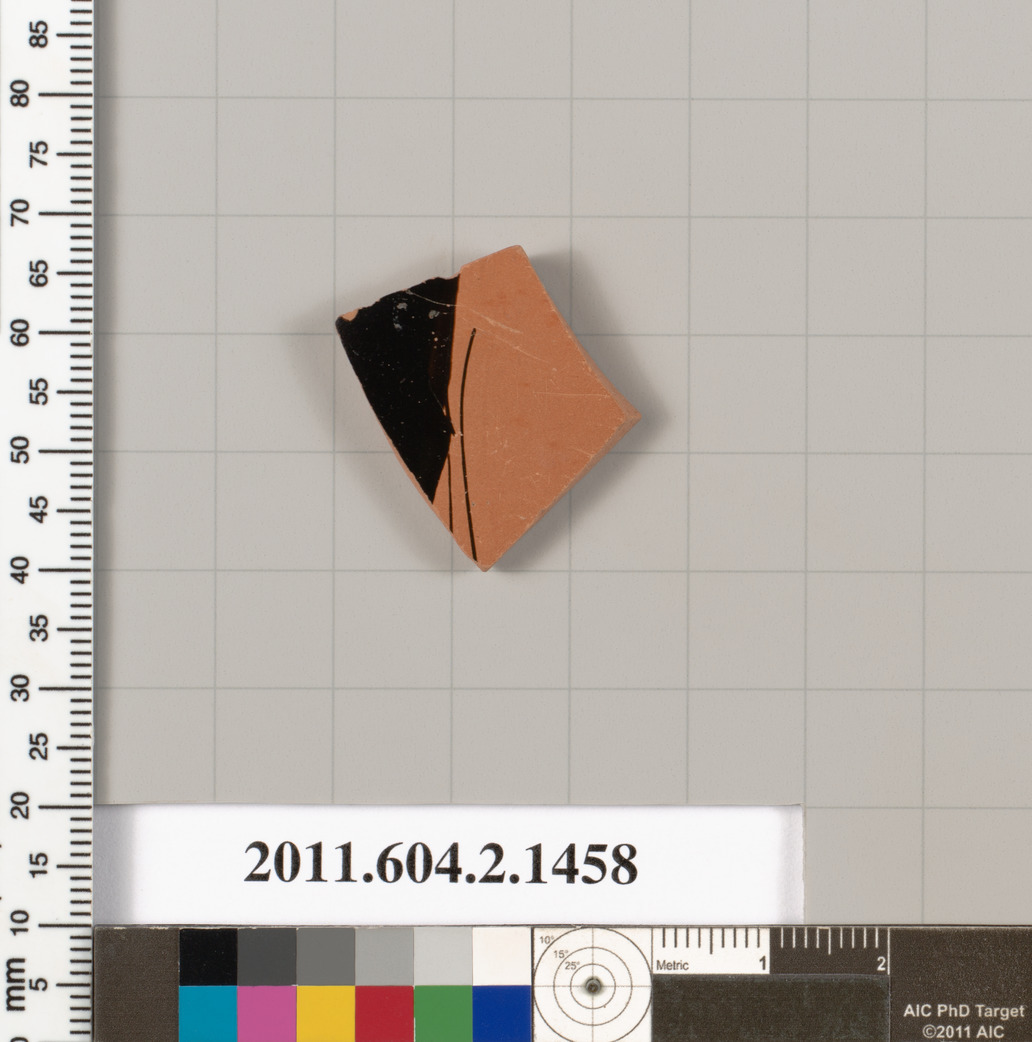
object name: skyphos fragment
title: Terracotta fragment of a skyphos (deep drinking cup)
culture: greek, attic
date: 475-451 BCE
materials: terracotta